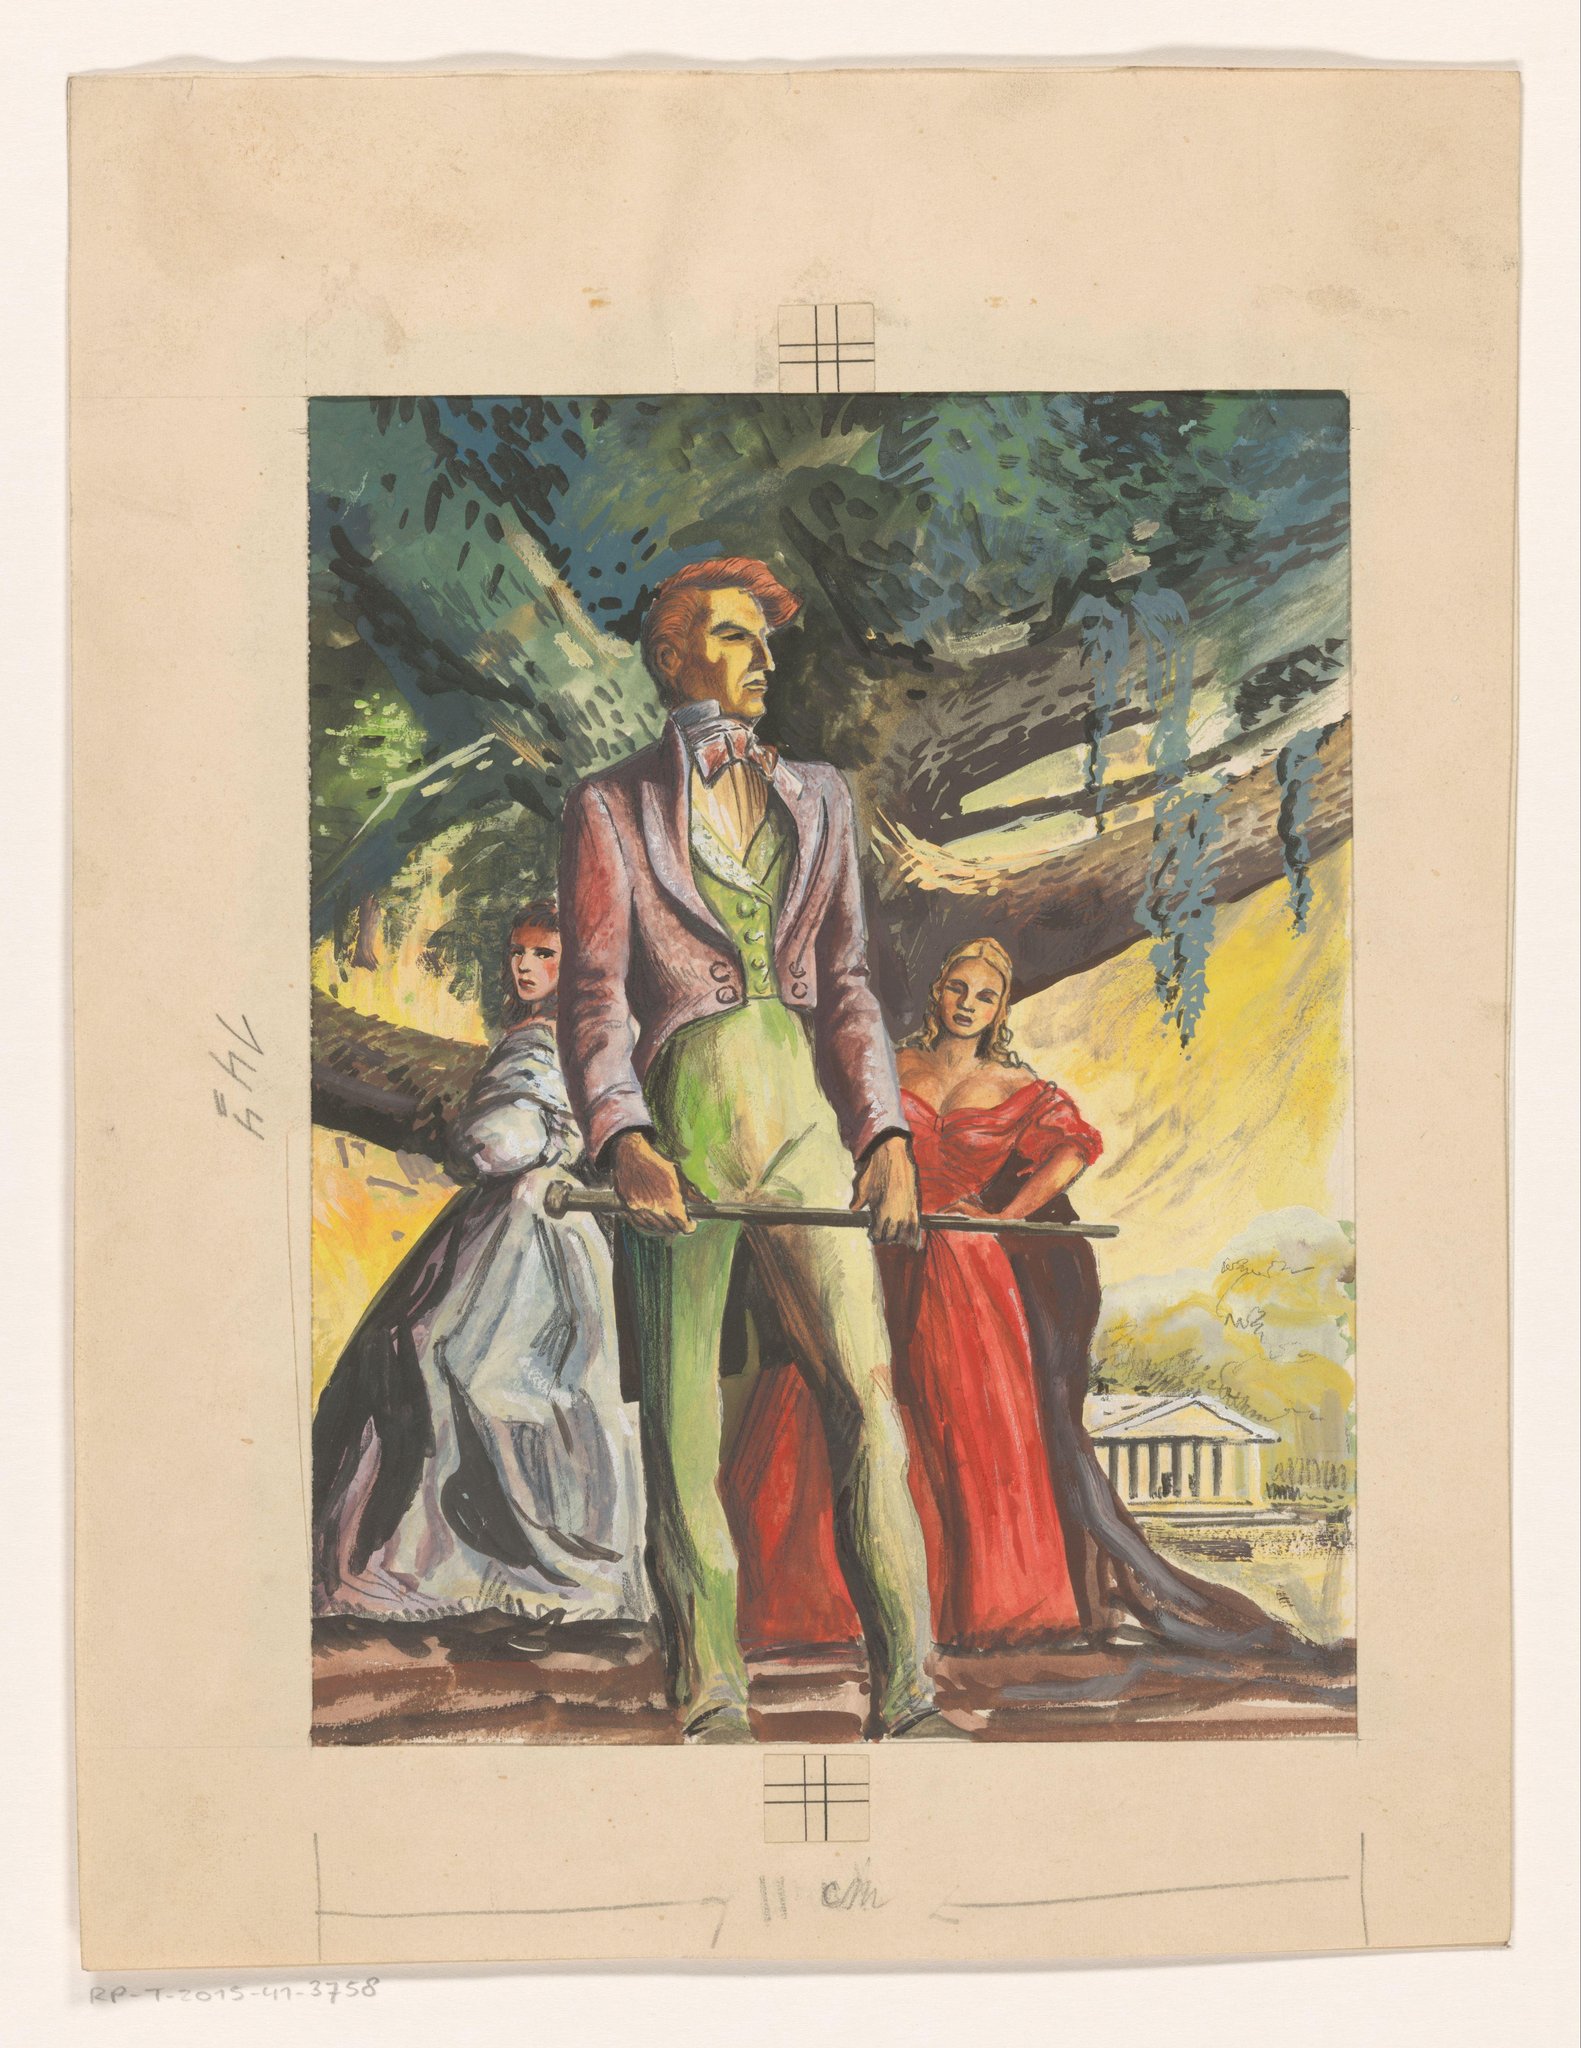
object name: drawing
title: Man en twee vrouwen voor een landhuis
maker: Anonymous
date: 1920-1970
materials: paint, paper, pencil, watercolor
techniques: brush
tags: historical costume, country-house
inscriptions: :, collector's mark: Lugt 2228a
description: Bij een boom staan twee vrouwen achter een man. Ze dragen negentiende-eeuws kostuum. In de achtergrond een landhuis met klassieke façade.